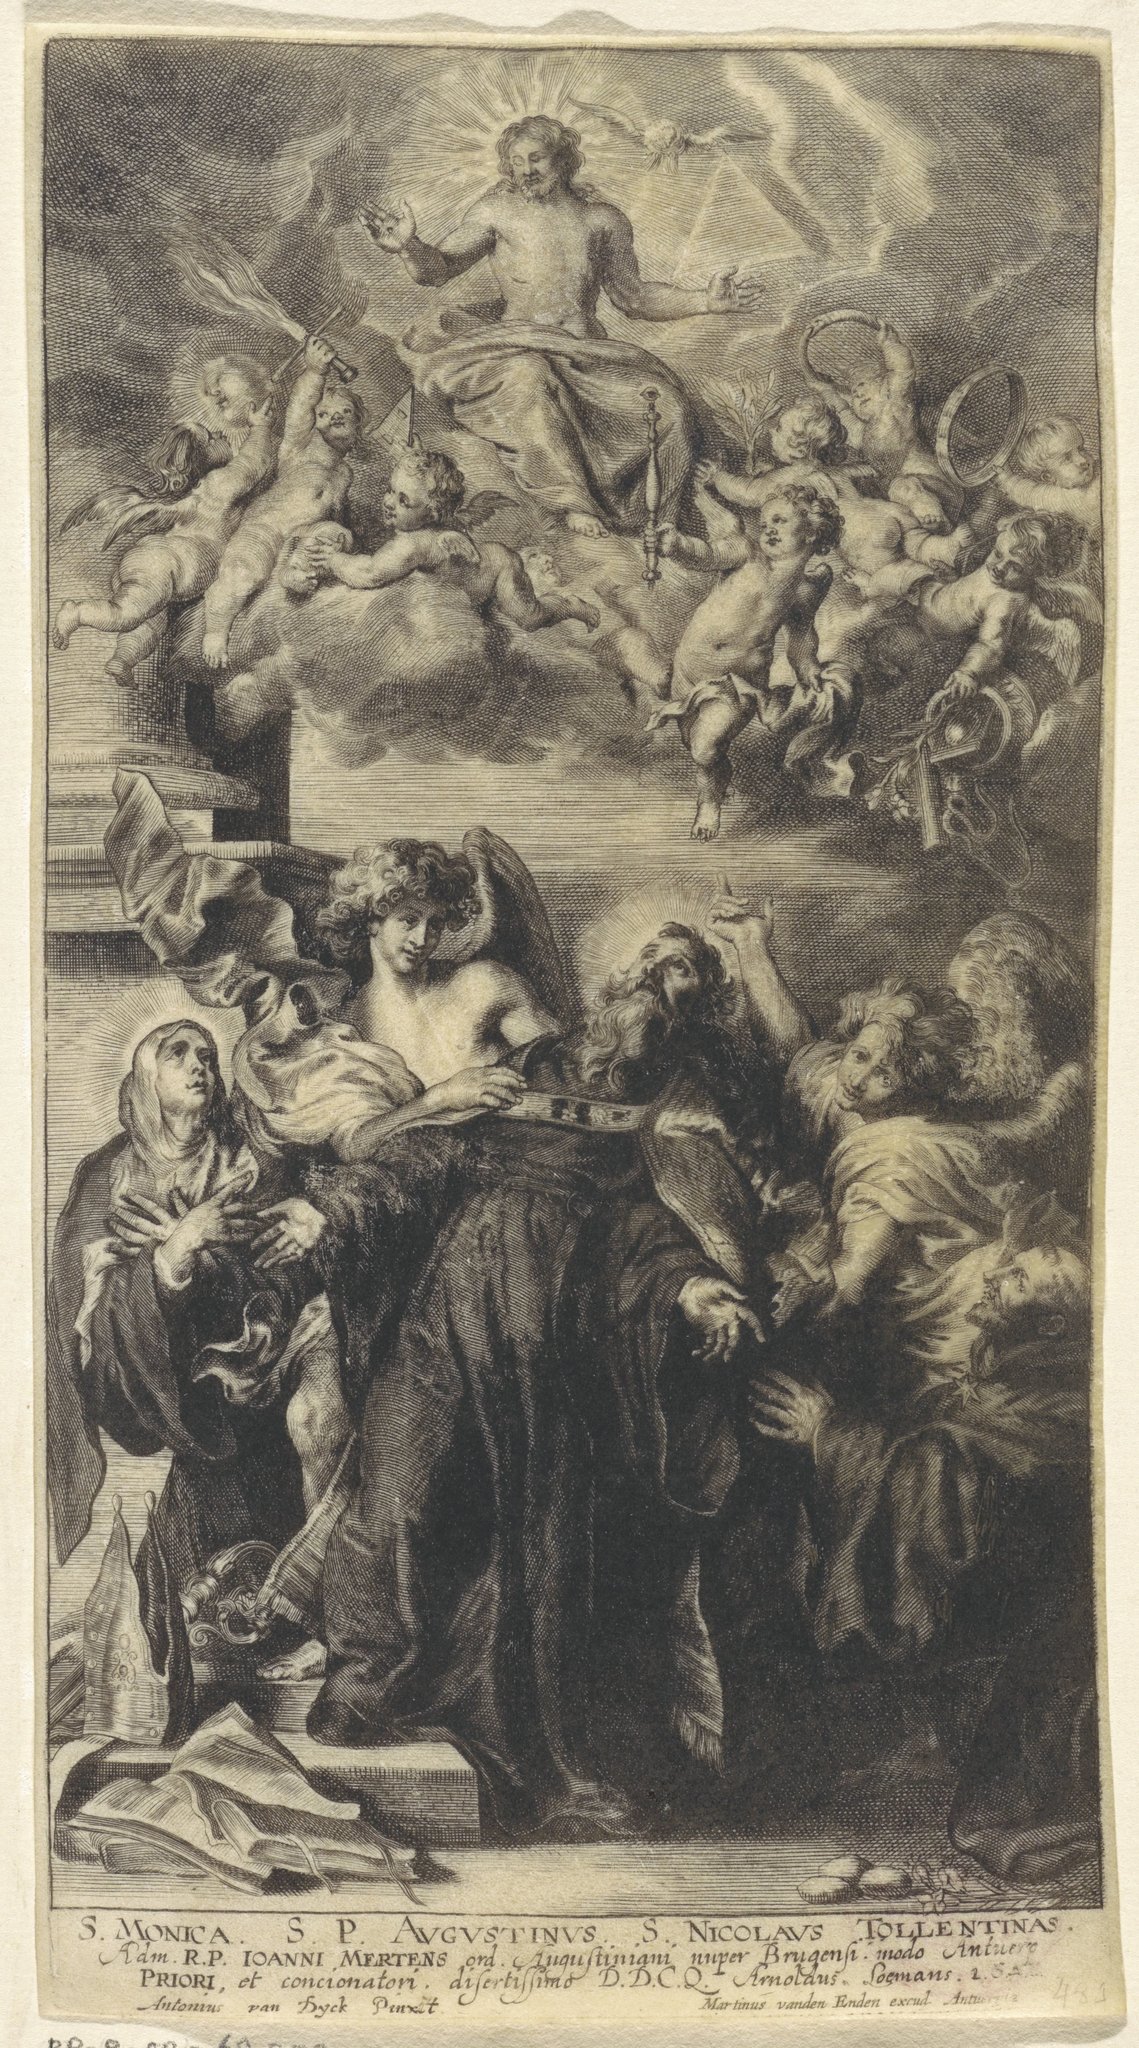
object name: print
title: Visioen van de H. Augustinus van Hippo met de H. Monica en de H. Nicolaas van Tolentino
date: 1642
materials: parchment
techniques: engraving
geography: antwerp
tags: augustine, bishop of hippo; possible attributes: arrows piercing his breast, book, child with spoon, flaming heart, heart (pierced with arrows), pen, adult christ together with angels, the mother of augustine, monica of tagaste (or ostia); possible attributes: black dress with white veil or wimple, book, crucifix, rosary, the augustine hermit, nicholas of tolentino; possible attributes: book, crucifix, (entwined with lilies), lily, (basket with) loaves, two doves (on a dish or flying away), star (on his breast)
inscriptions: collector's mark: Lugt 240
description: In het midden staat de H. Augustinus van Hippo. Hij draagt een koorkap over zijn augustijner monnikspij en wordt geflankeerd door twee engelen. Links staat zijn moeder, de H. Monica, en rechts knielt de H. Nicolaas van Tolentino. Nicolaas van Tolentino draagt eveneens een augustijner monnikspij met een ster, die verwijst naar het visioen voor zijn dood. Voor hem liggen drie kleine broden als verwijzing naar het wonder van de koortsbroden. Linksvoor enkele geschriften, een mijter en een bisschopsstaf. Alle heiligen kijken omhoog, waar Christus met de Heilige Geest op een wolk troont. Hij wordt omgeven door engelen met verschillende attributen, onder andere een vlammend zwaard, een oog op een staf, een ring die in zijn eigen staart bijt (symbool van eeuwigheid) en een olijftak. In de marge een drieregelige opdracht in het Latijn.